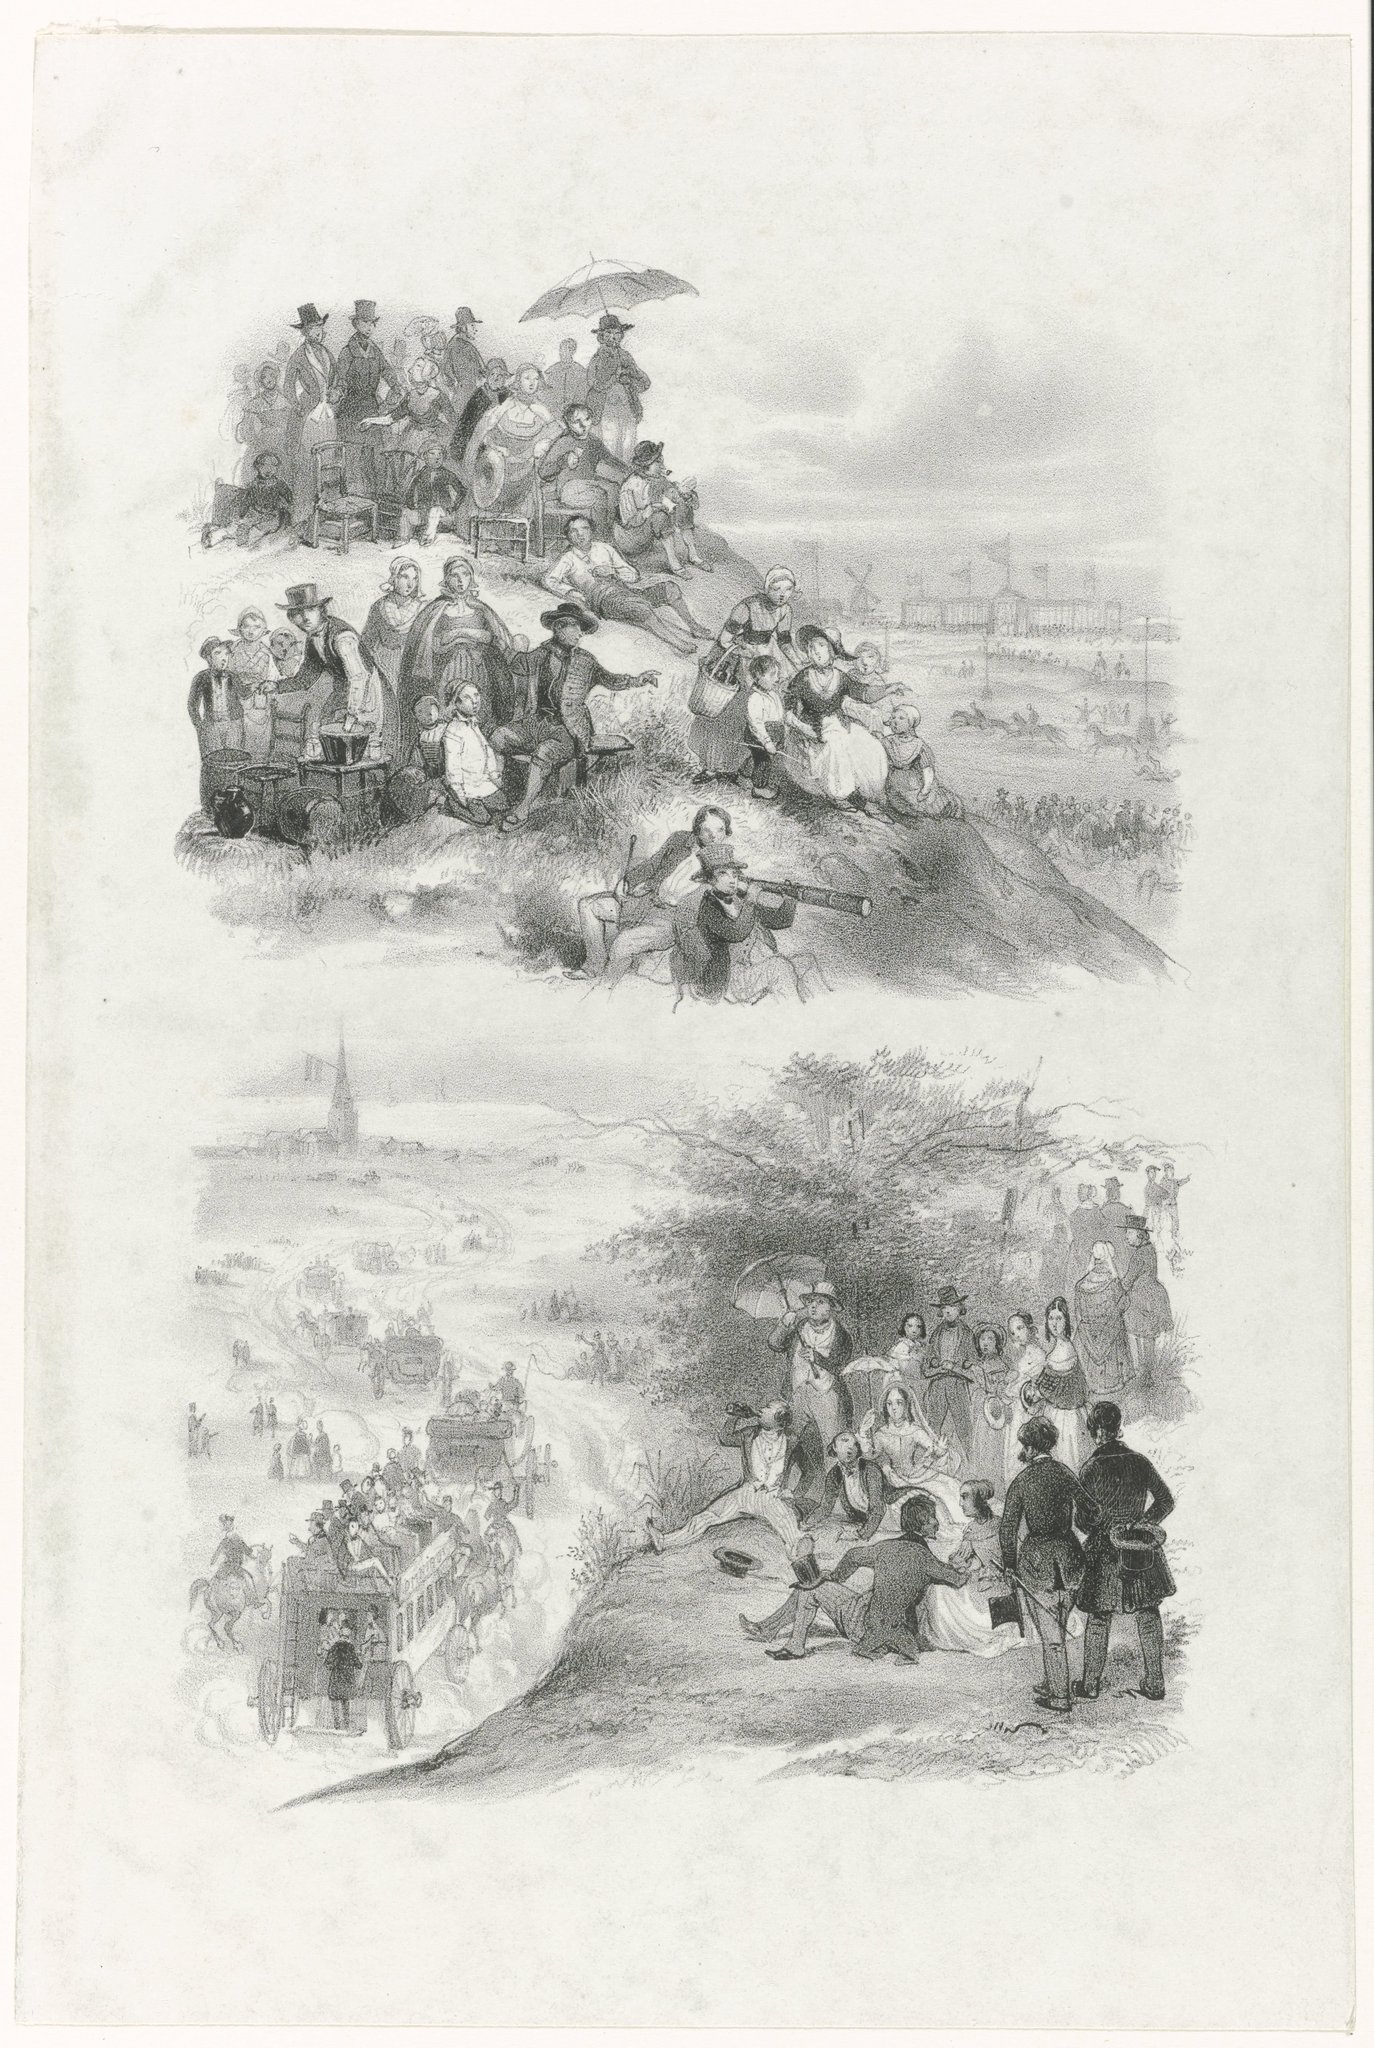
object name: print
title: Wedren te Scheveningen, 3 augustus 1846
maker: Anonymous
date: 1846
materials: paper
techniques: lithograph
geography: netherlands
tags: diligence, omnibus, horse-tram, picnic, alfresco, 'déjeuner sur l'herbe', race-track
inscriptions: collector's mark: Lugt 2228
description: Twee voorstellingen van het publiek bij het paardenrennen te Scheveningen op 3 augustus 1846. Bovenaan het publiek zittend in de duinen, op de voorgrond een man met een telescoop. Onderaan de terugkeer van het publiek naar Scheveningen na de wedstrijd, over de weg rijdt een omnibus.